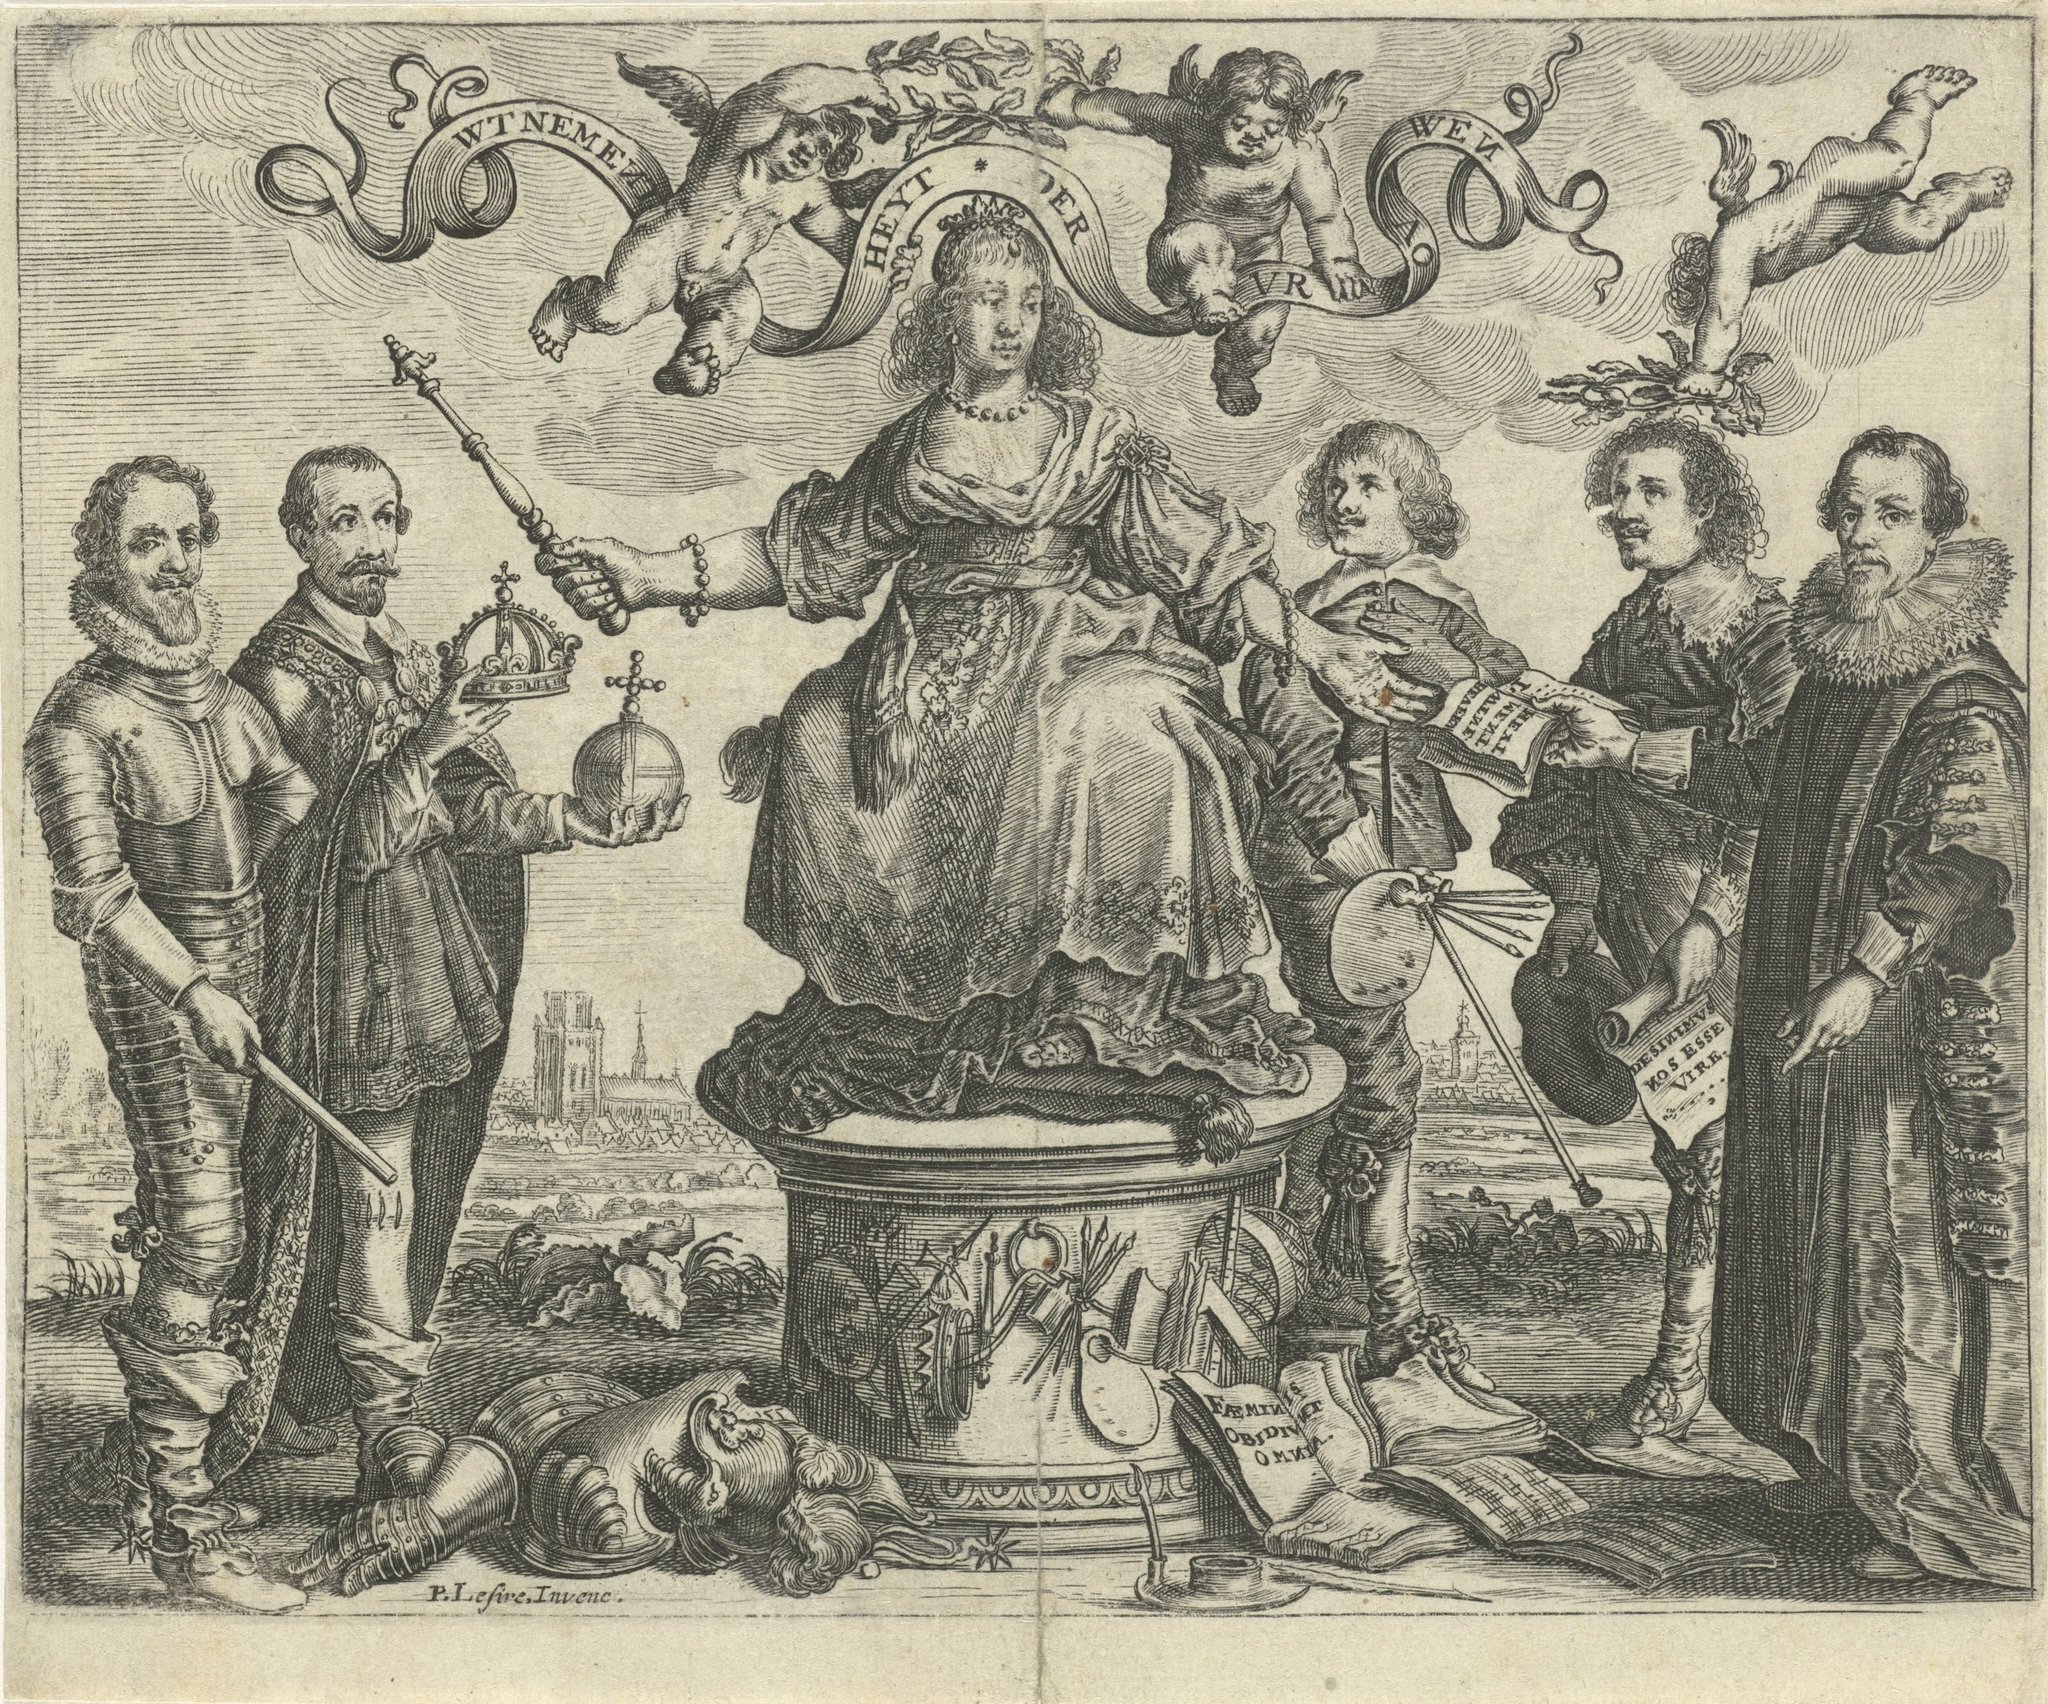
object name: book illustration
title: Vijf mannen bieden een vrouw attributen aan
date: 1643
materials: paper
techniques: engraving, etching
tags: crown (symbol of sovereignty), orb (symbol of sovereignty; sphere with cross on top), sceptre, staff (symbol of sovereignty), tools, implements of painter, book, crowning with laurel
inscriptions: collector's mark: Lugt 2228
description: Een vrouw staat met een scepter in haar hand op een sokkel en wordt gelauwerd door twee putti. Links houden twee mannen een scepter, kroon en een rijksappel (symbolen voor soevereiniteit ) vast. Rechts staan drie mannen met een schilderspalet, boekrol en een boekwerk (symbolen voor de kunsten). Het boekwerk wordt door de vrouw geaccepteerd. Op de voorgrond liggen een harnas, opengeslagen boeken en muziekstukken.